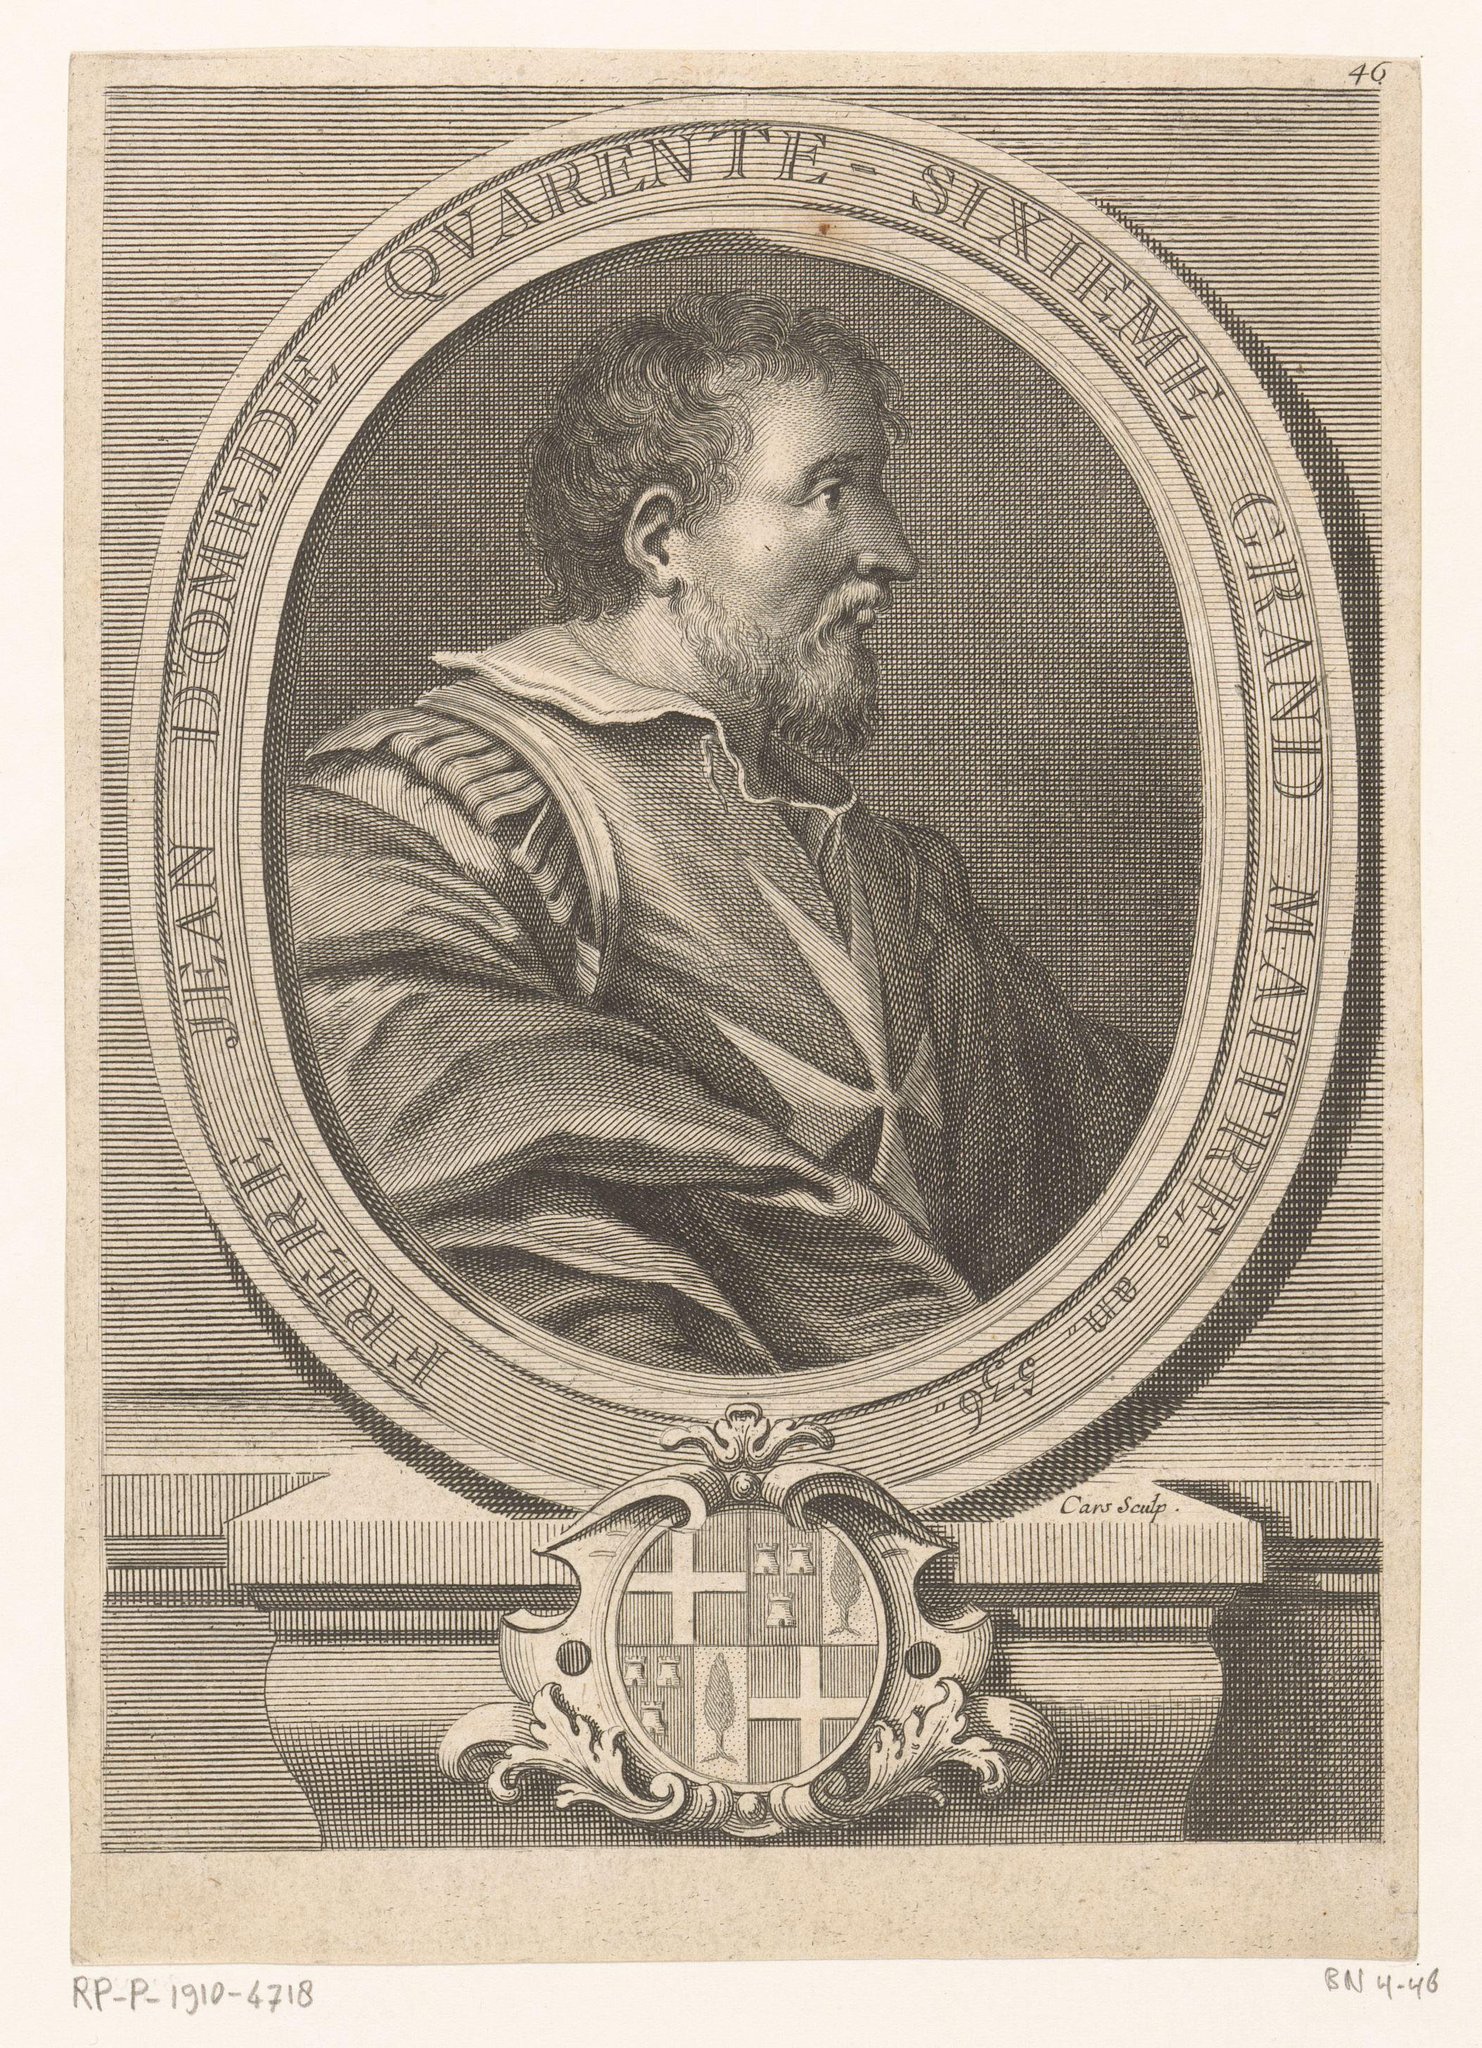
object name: print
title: Portret van Juan de Homedes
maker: laurent cars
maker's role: print maker, publisher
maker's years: 1699-1771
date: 1726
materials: paper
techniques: engraving, etching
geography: france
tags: historical persons, military orders, e.g.: knights templars, knights of malta, teutonic knights ~ roman catholic church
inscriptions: collector's mark: Lugt 2228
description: Prent uit: Vertot, René Aubert de. Histoire des Chevaliers hospitaliers de St Jean de Jérusalem. Parijs: Rollin, Quillau, Desaint, 1726. Illustratie op p. 175 van deel 3. Cars vervaardigde portretten van 65 grootmeesters van de Maltezer Orde.